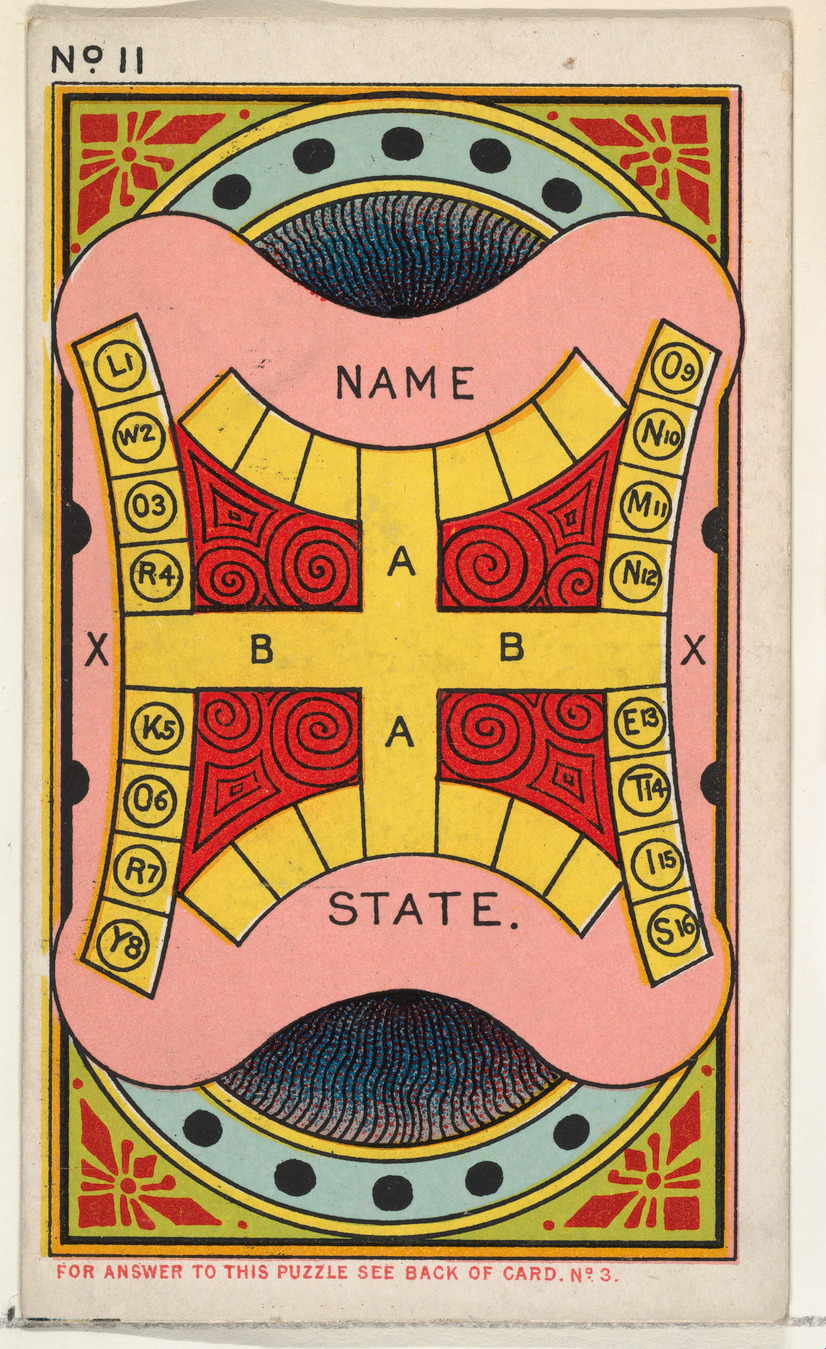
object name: print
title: Puzzle Card Number 11, A "Public Man" Puzzle, from the Jokes series (N118) issued by Duke Sons & Co. to promote Honest Long Cut Tobacco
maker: w. duke, sons & co.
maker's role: publisher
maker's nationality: american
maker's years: 1870-1920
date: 1890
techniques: color lithograph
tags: playing cards